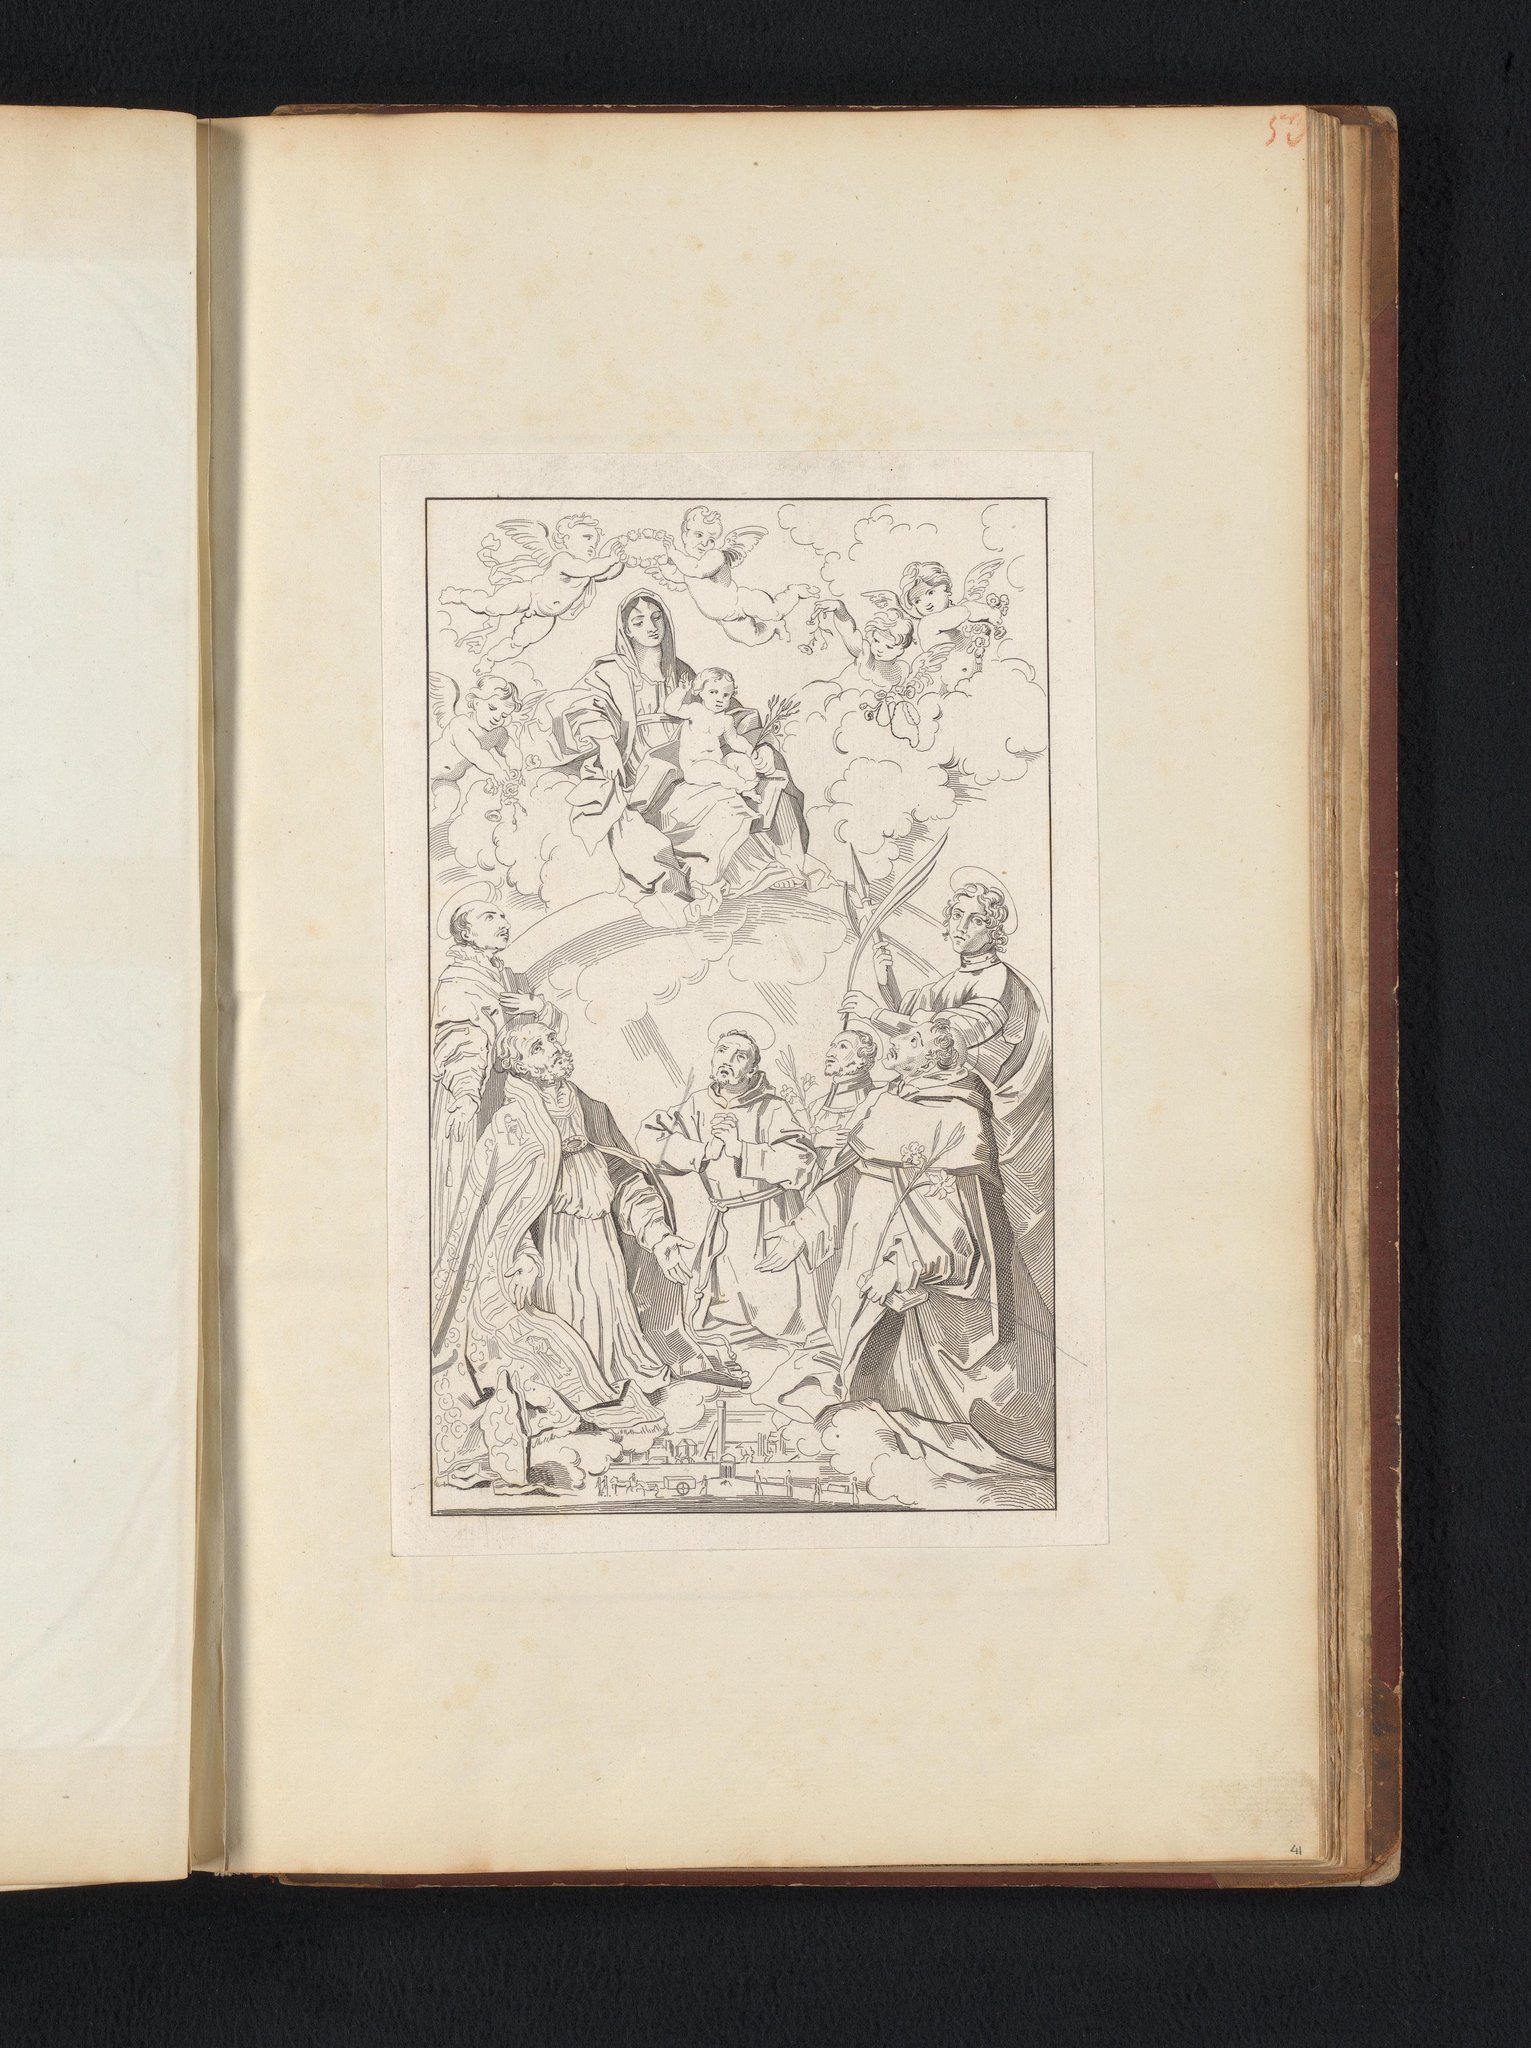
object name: print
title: Maria met kind in de wolken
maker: Anonymous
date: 1750-1816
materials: paper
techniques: etching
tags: madonna (i.e. mary with the christ-child) in the air, or on the clouds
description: Ingeplakte prent van Maria met kind in de wolken. Onderdeel van het tweede van twee albums met ingeplakte prenten en tekeningen te dienen als tekenvoorbeelden.